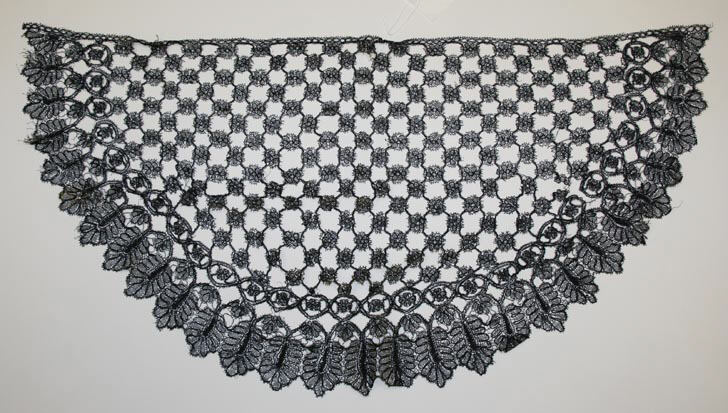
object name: veil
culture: french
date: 1834-1866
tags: flowers